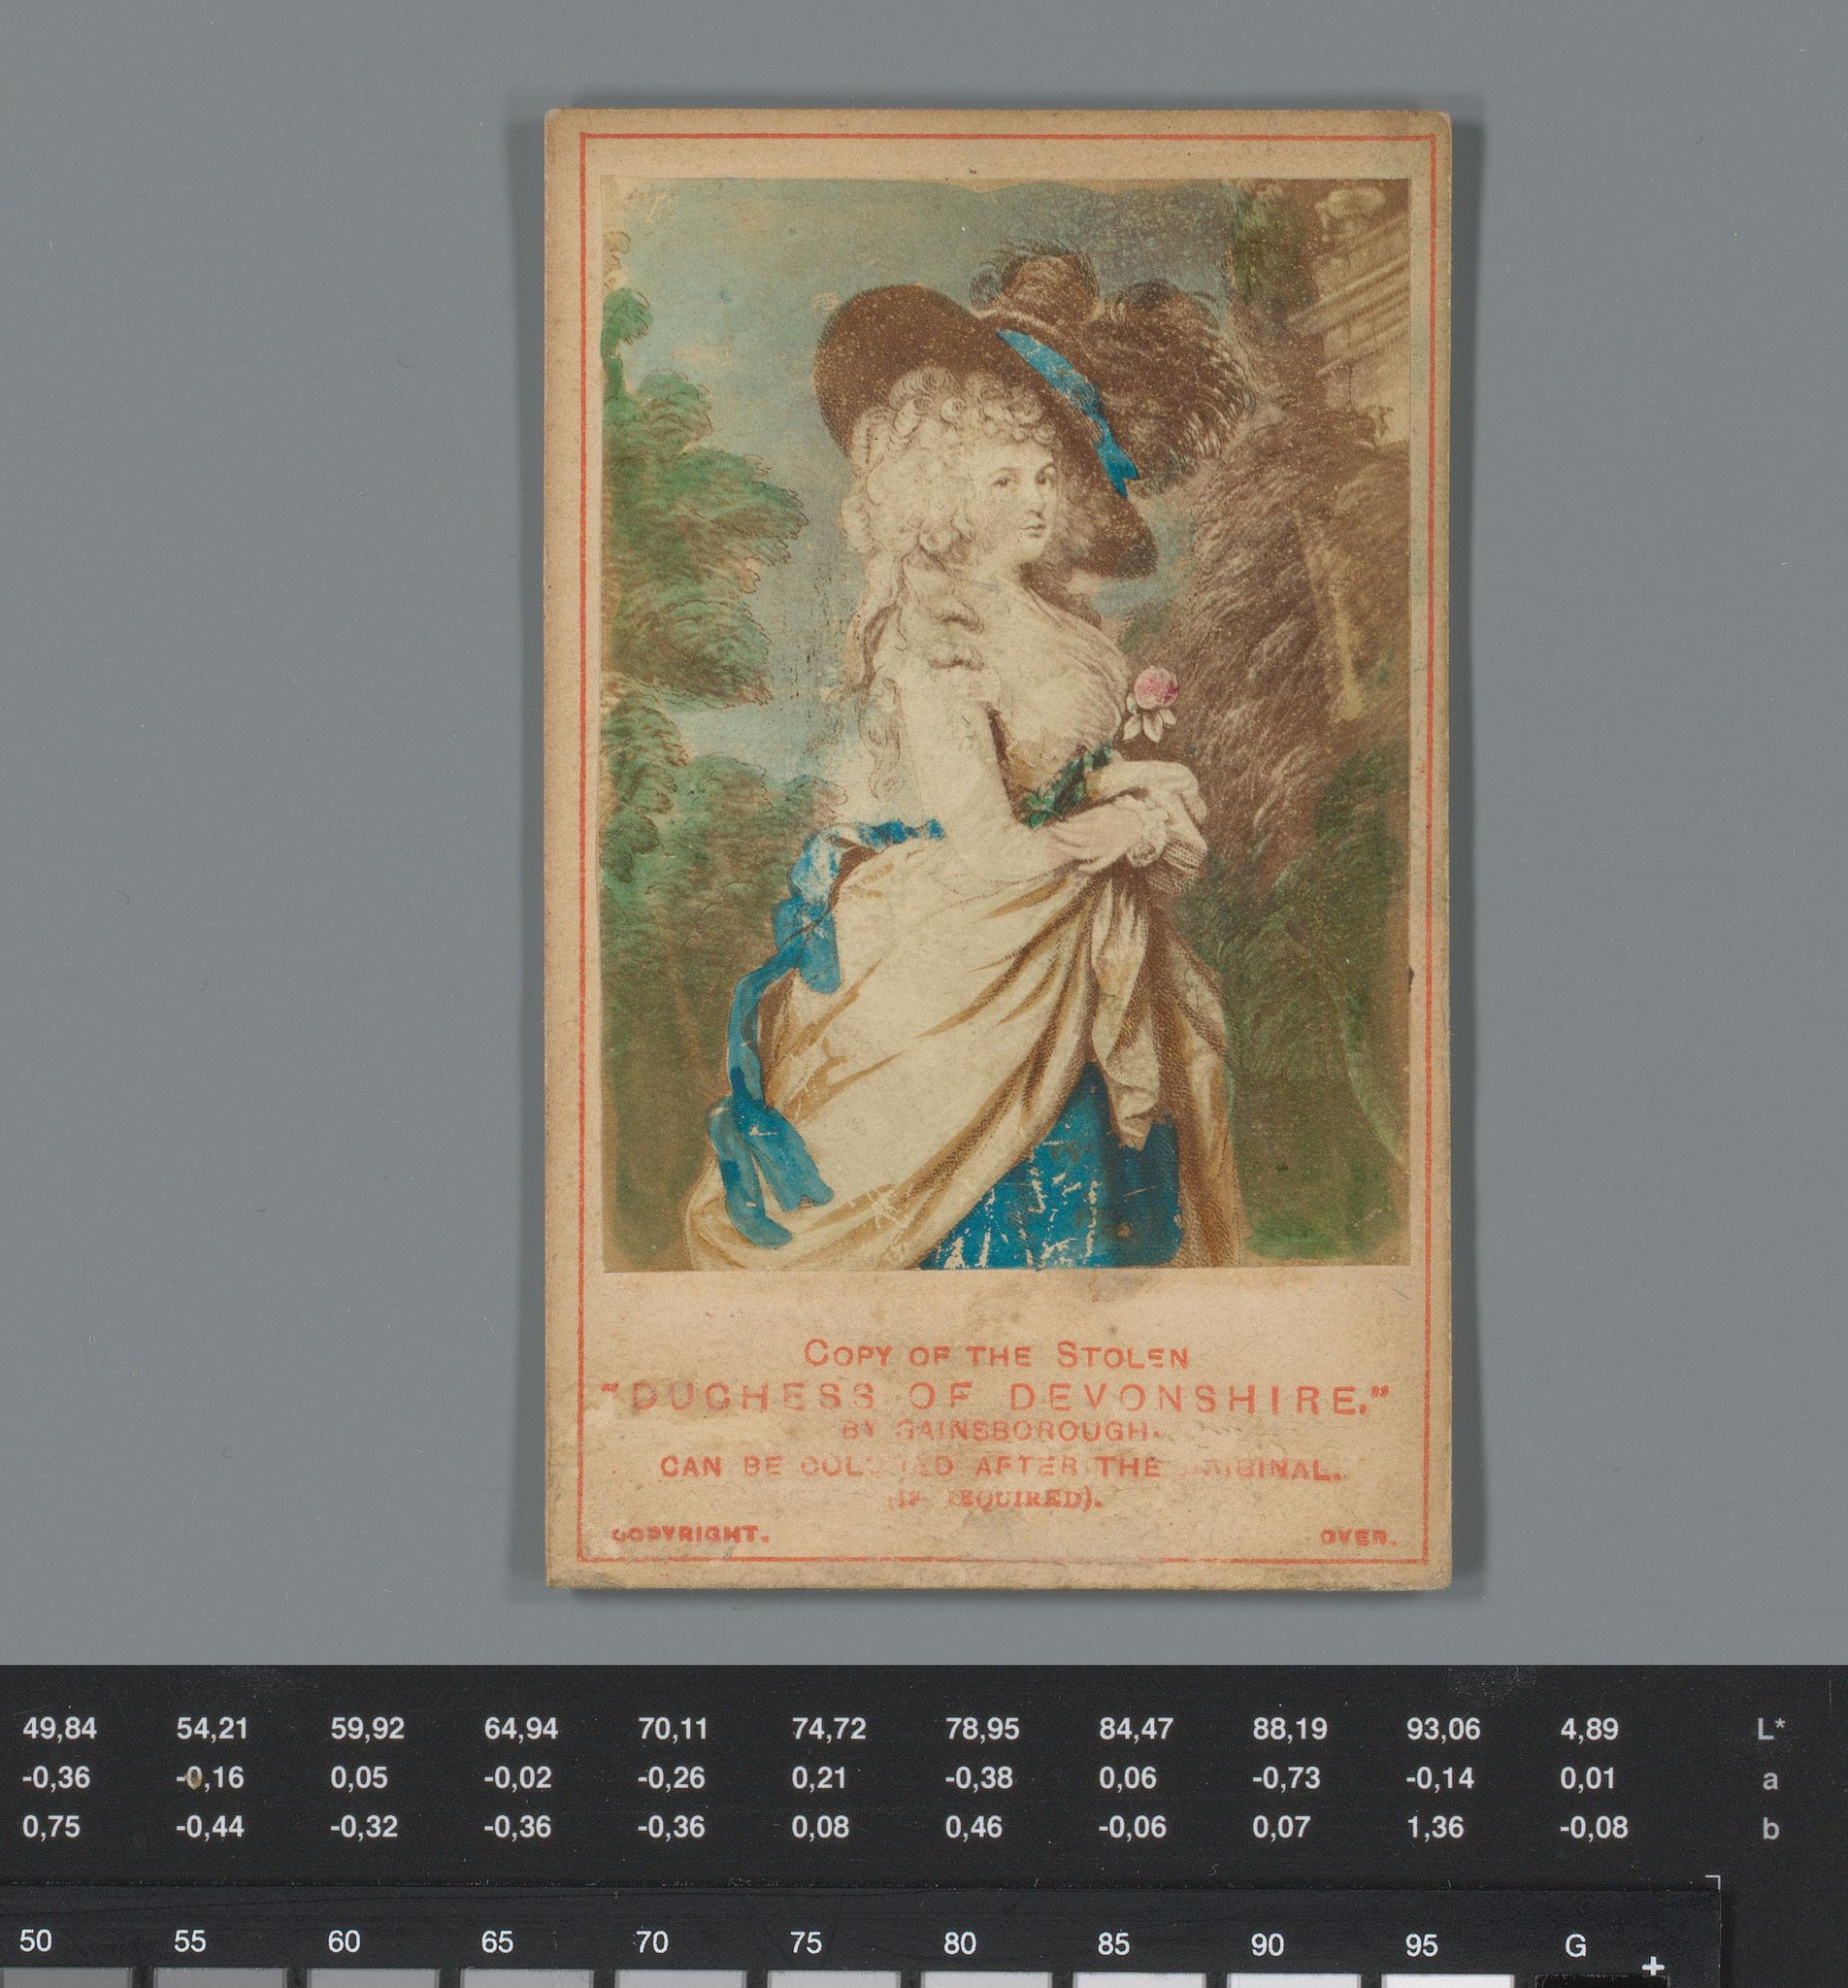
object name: reproduction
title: Reproductie van een vermist schilderij van Thomas Gainsborough met een oproep en beloning voor de vinder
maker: thomas gainsborough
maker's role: draughtsman, painter, print maker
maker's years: 1727-1788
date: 1850-1915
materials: cardboard, paint, photographic support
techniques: albumen print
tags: london, georgiana spencer (hertogin van devonshire), advertising, historical persons - bb - woman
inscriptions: inscription: ‘THE DUTCHESS OF DEVONSHIRE / BY GAINSBOROUGH / This celebrated picture was purchased by Messrs Agnew, (...) it was stolen on the night of the 25th of May, being cut out of the frame. / £1000 is offered by Messrs. Agnew or the recovery of the picture, and conviction of the thief or thieves. (...)’